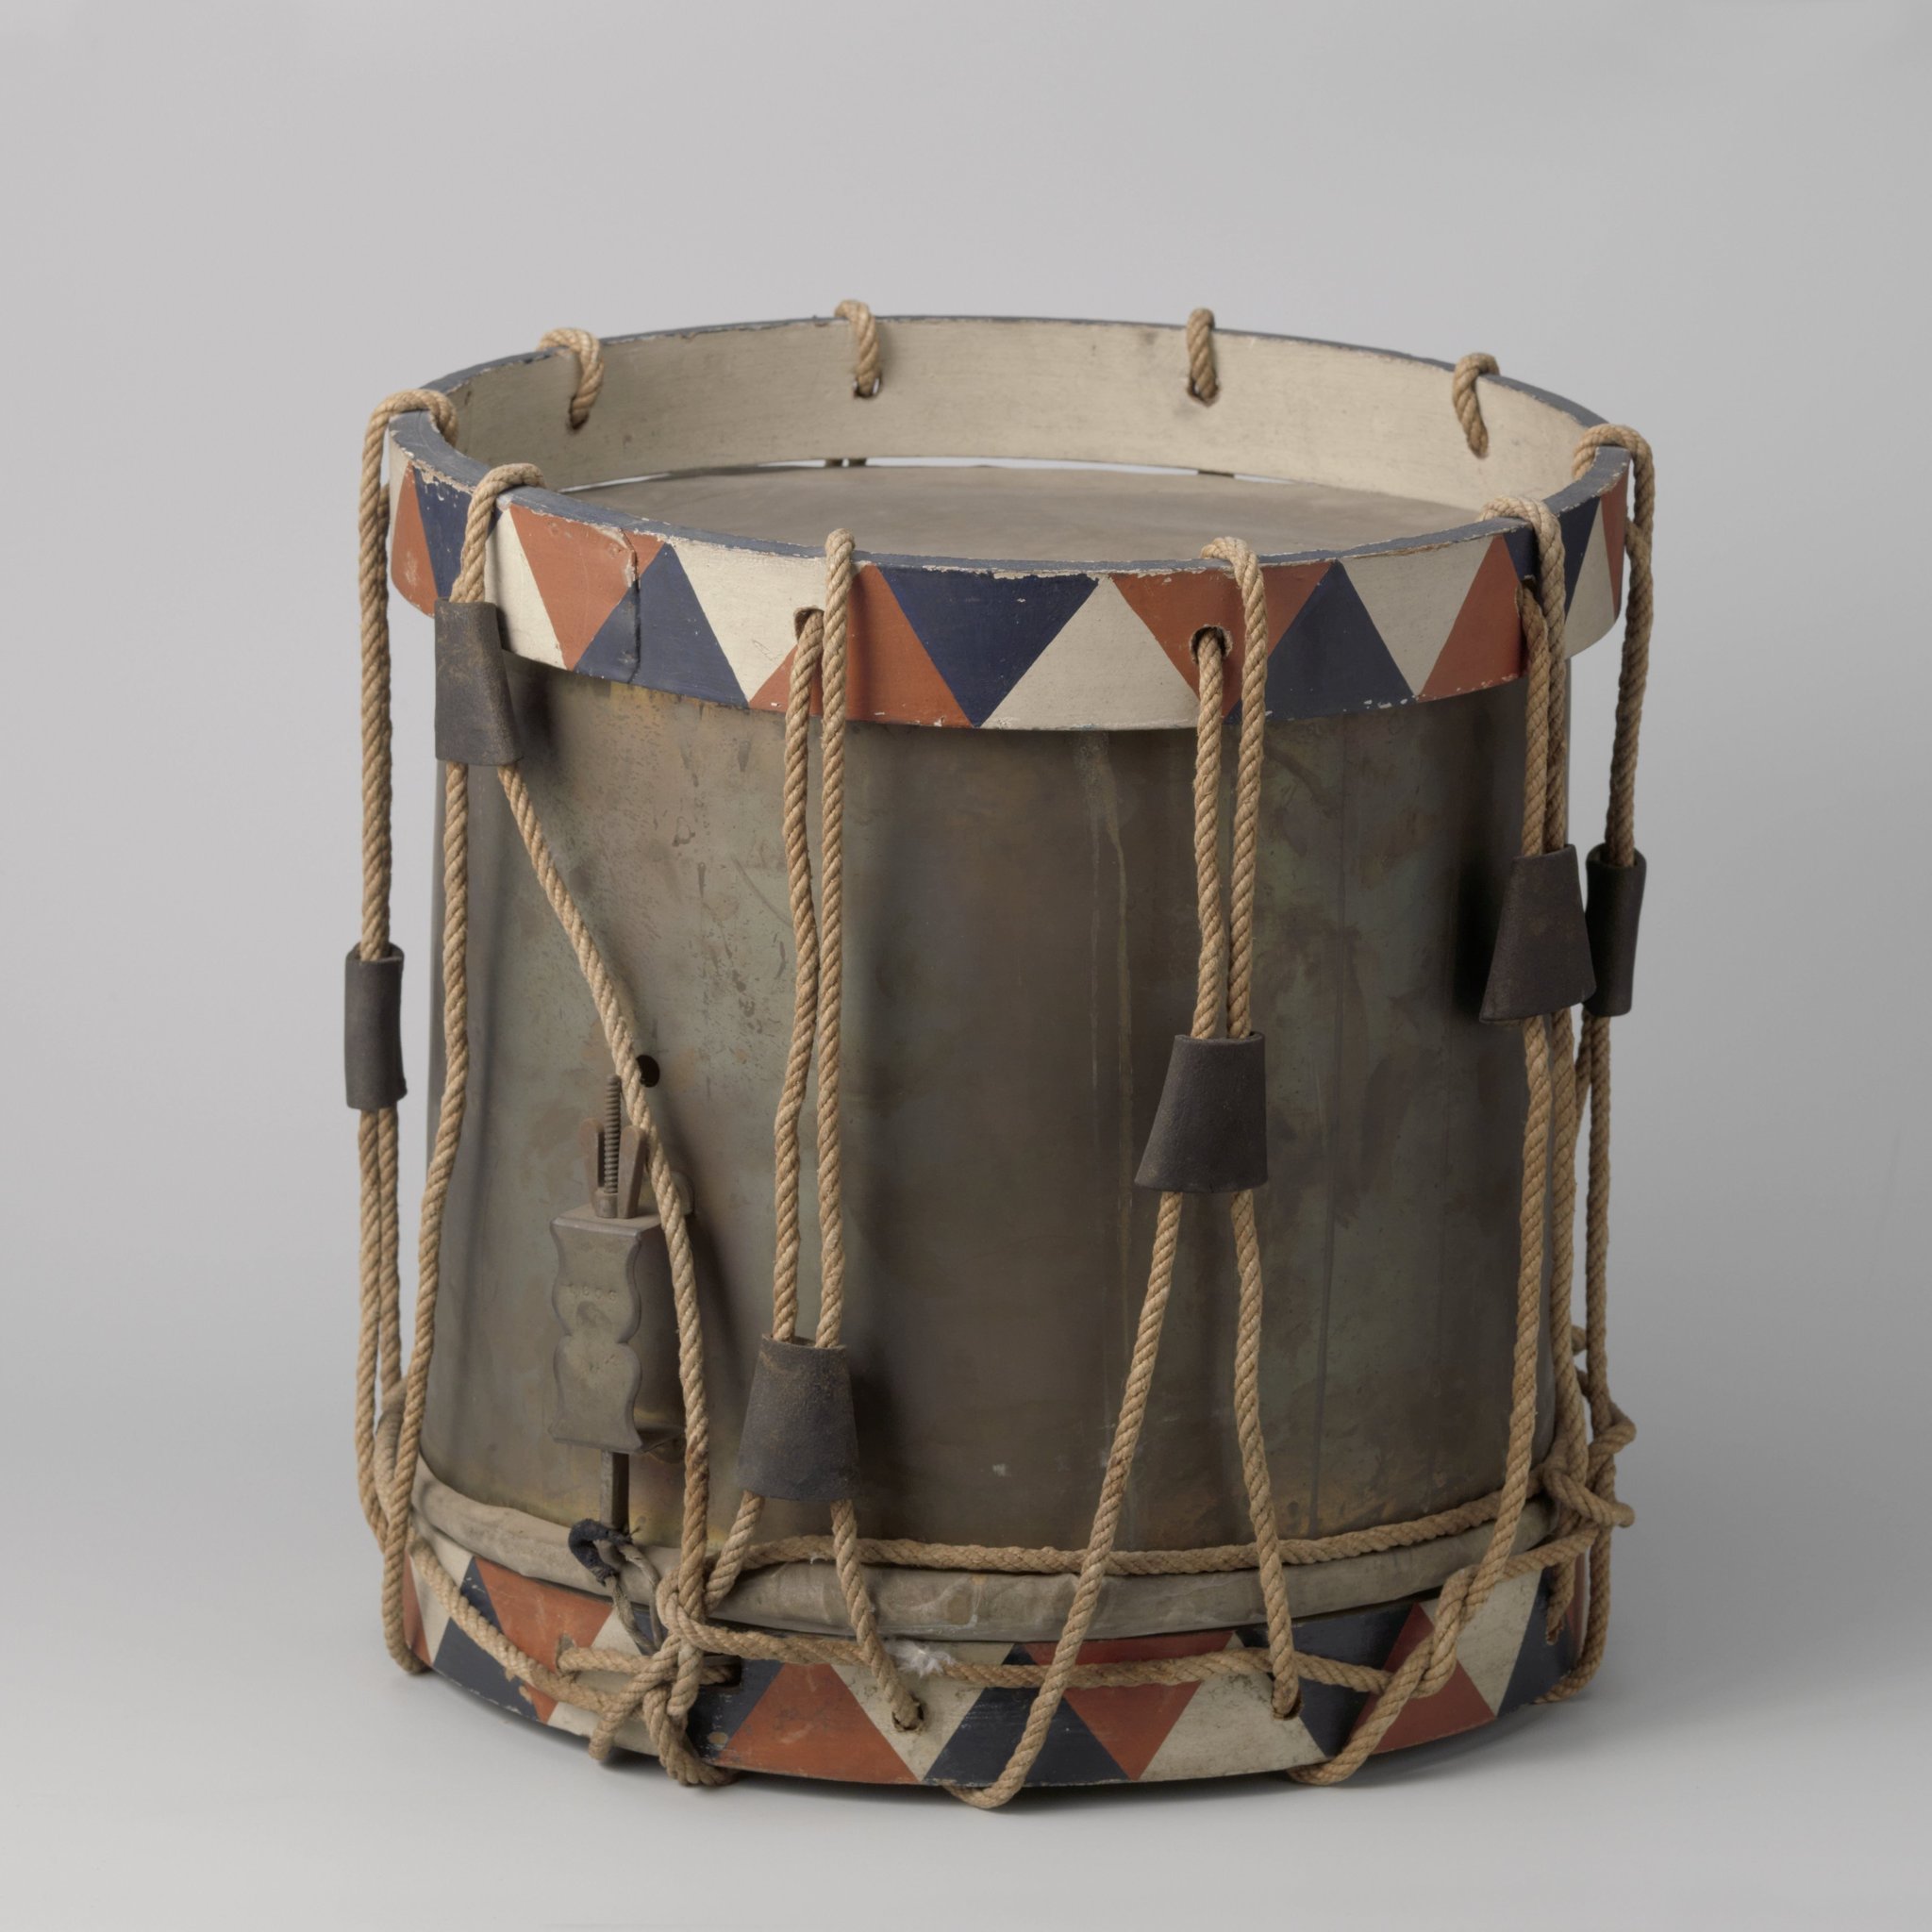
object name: percussion instrument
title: Side Drums (39 x)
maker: Anonymous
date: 1853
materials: brass, fiber, skin, wood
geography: netherlands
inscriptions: inscription: ‘1853-5’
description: Music has always been a crucial element of public celebrations, such as military parades, coronations, royal weddings, and funerals, adding grandeur to the solemnity of the occasion. Musical ensembles entrusted with performing music at these events have existed in Europe since the Middle Ages. This display highlights various marching bands and their musical instruments dating from the 16th to the 19th century.